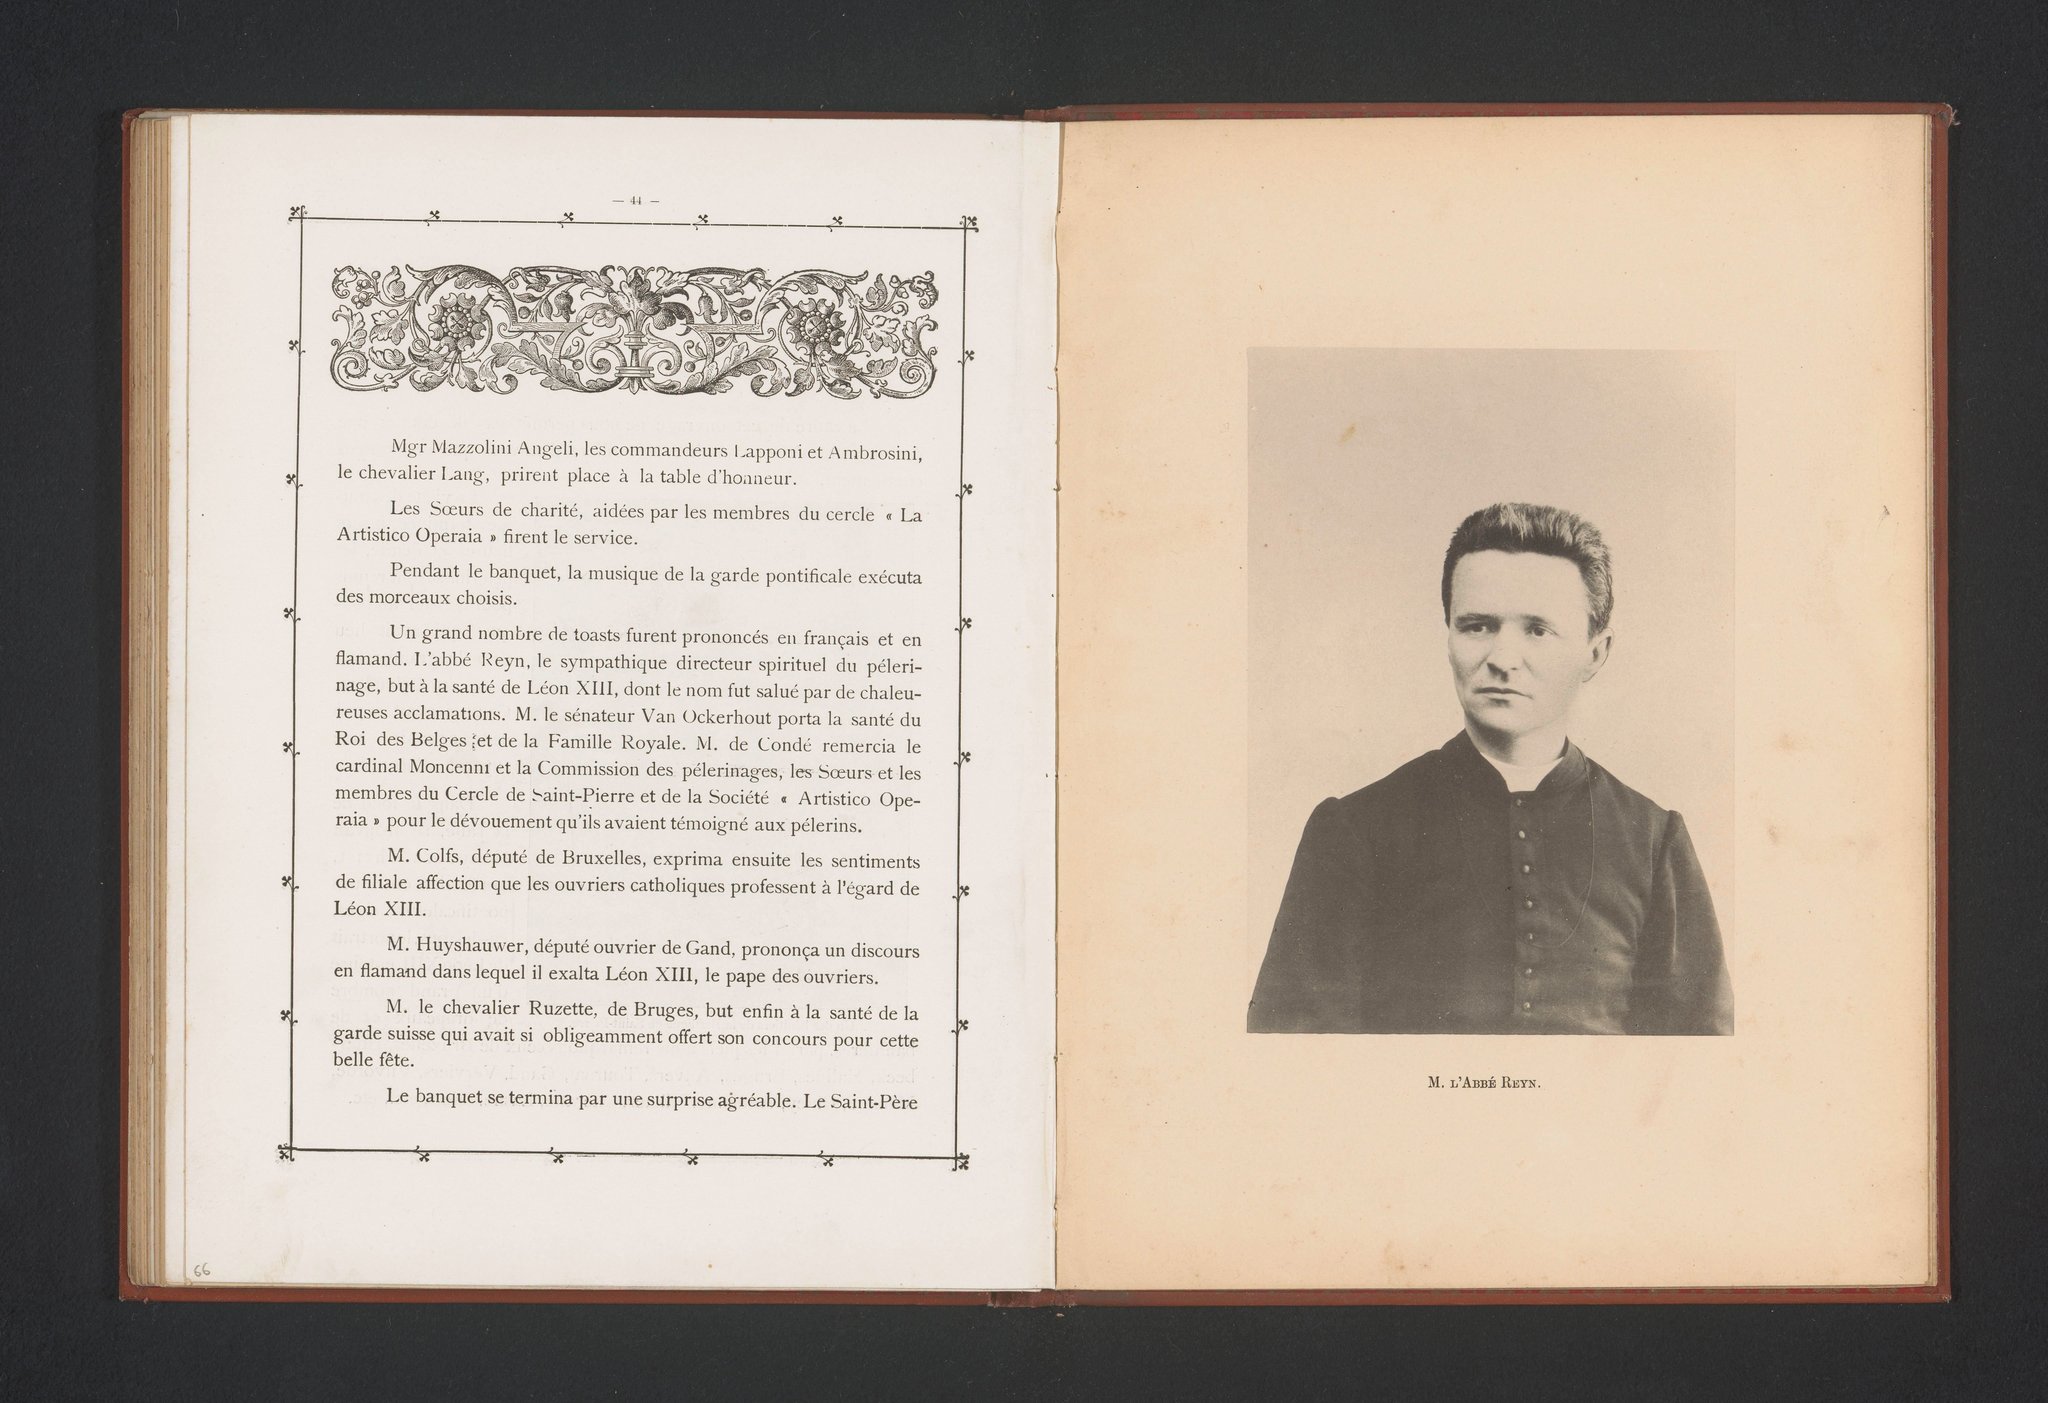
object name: page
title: Portret van abt Théofiel Reyn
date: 1893-1898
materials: paper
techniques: photograph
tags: brussels, historical persons